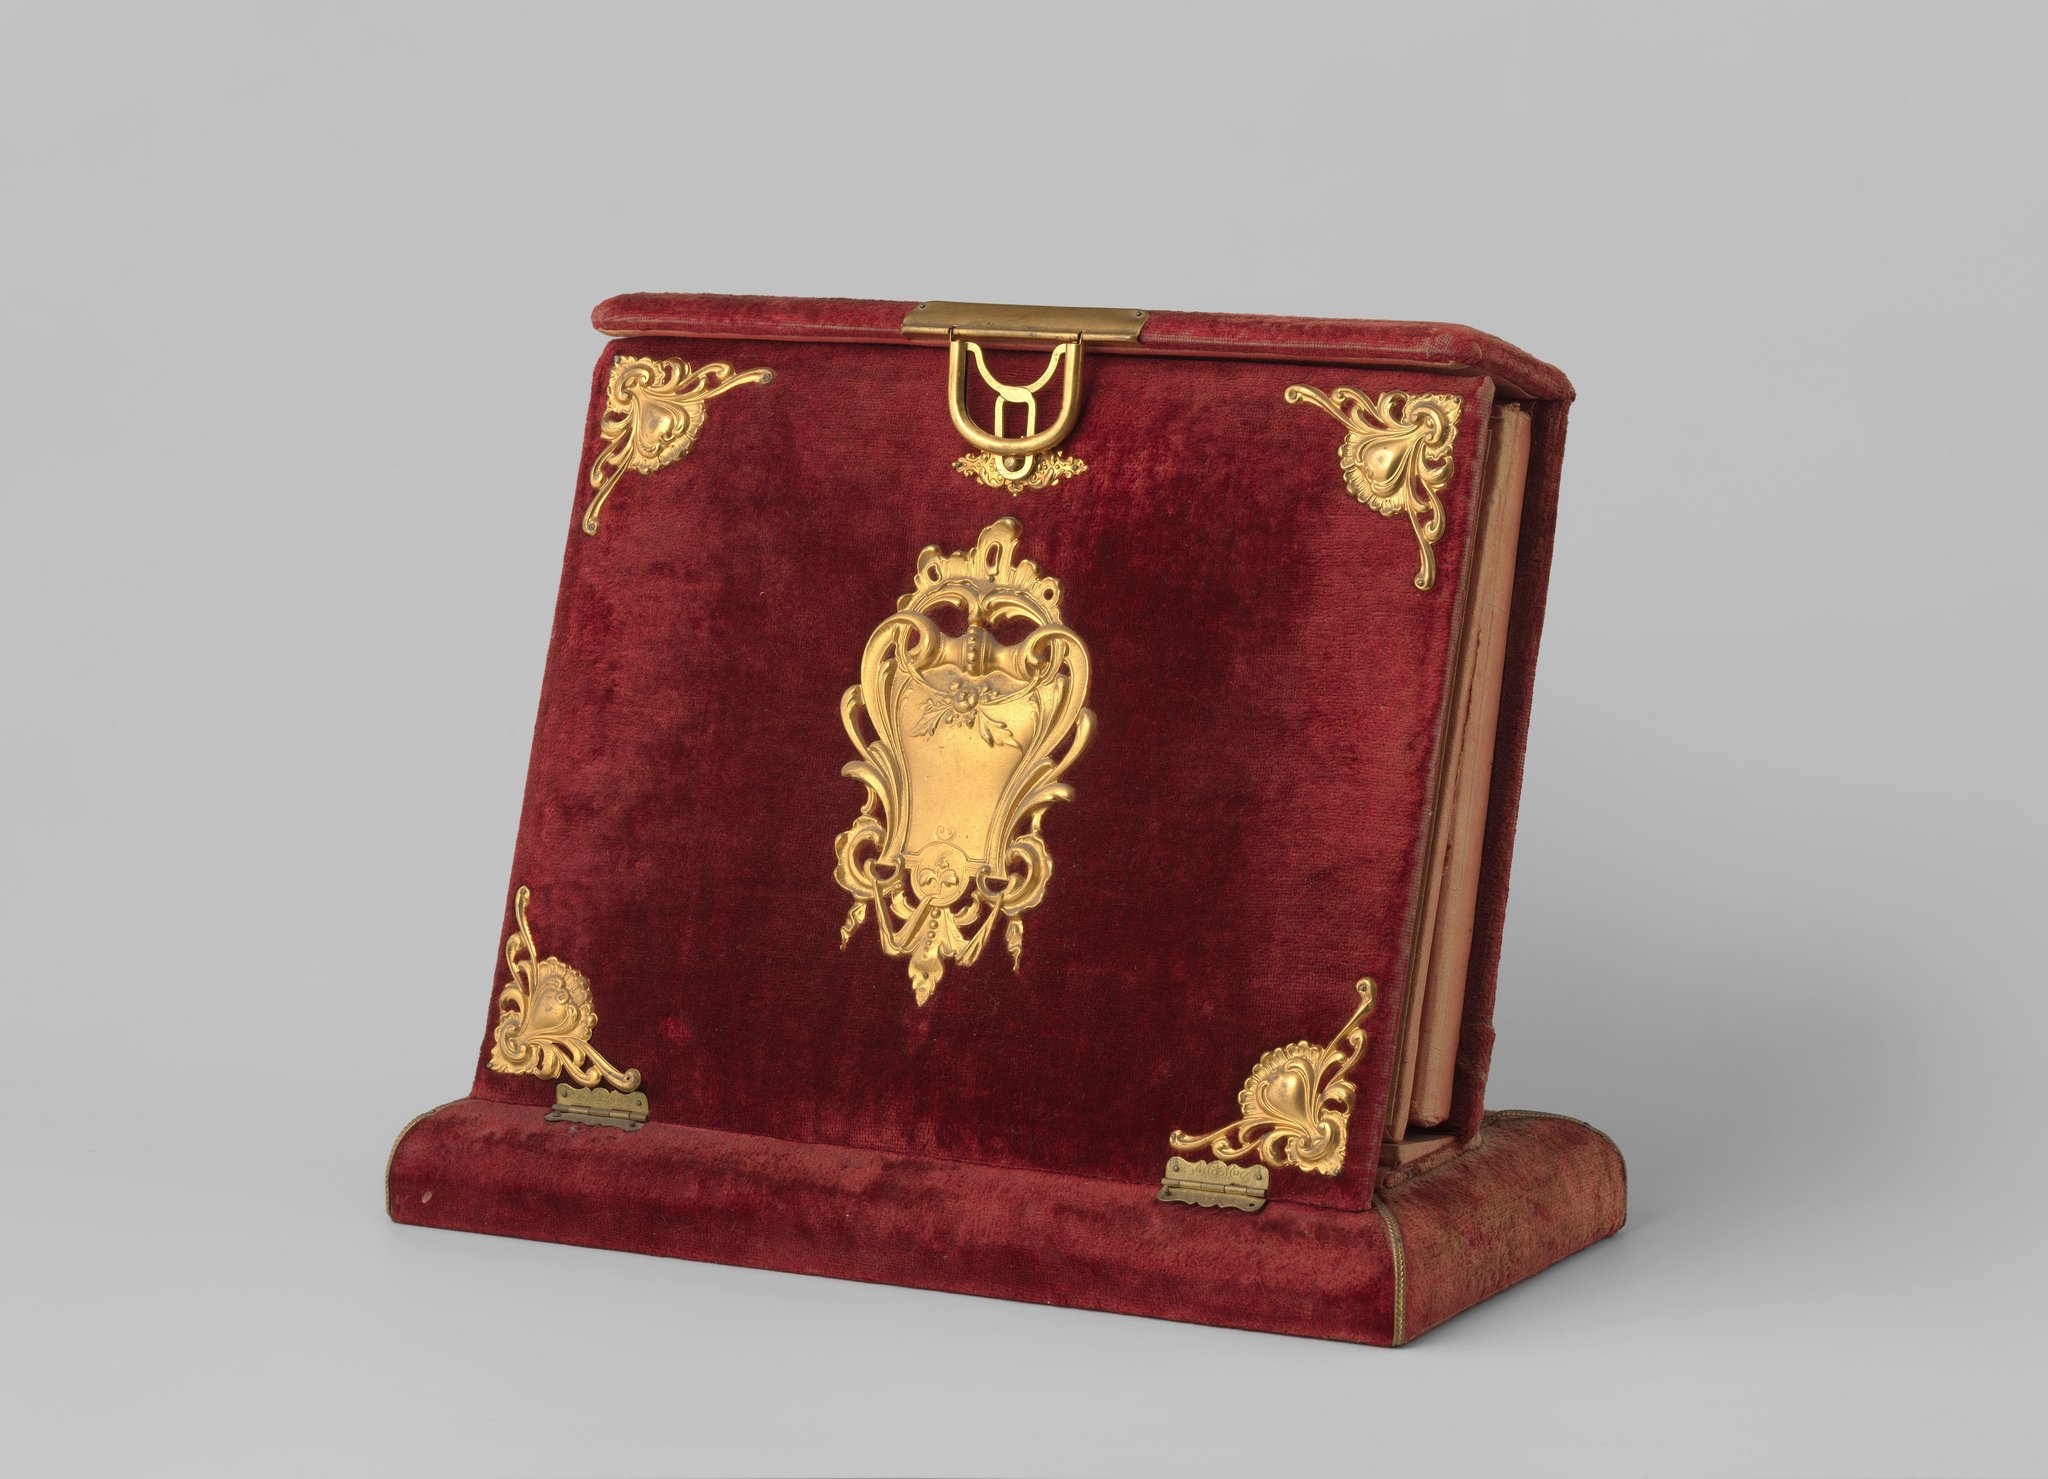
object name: musical box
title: Fotoalbum (leeg)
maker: Anonymous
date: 1860-1900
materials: cardboard, metal, paper, textile, silk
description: Insteek-album met speeldoos. Het album staat verticaal op een bodemplaat waarin een speeldoosmechanisme is bevestigd. Het album vouwt naar voren toe open. Aan het verticaal staande achterplat zijn twee bladen bevestigd met passe-partouts voor kabinetfoto's, die naar links en naar rechts uitvouwen. Aan het deel van het album dat naar voren toe opvouwt zijn drie bladen bevestigd met passe-partouts voor cartes-de-visite, die naar voren, rechts en links openvouwen. In totaal is er in het album plaats voor 10 kabinetfoto's en 21 cartes-de-visite.